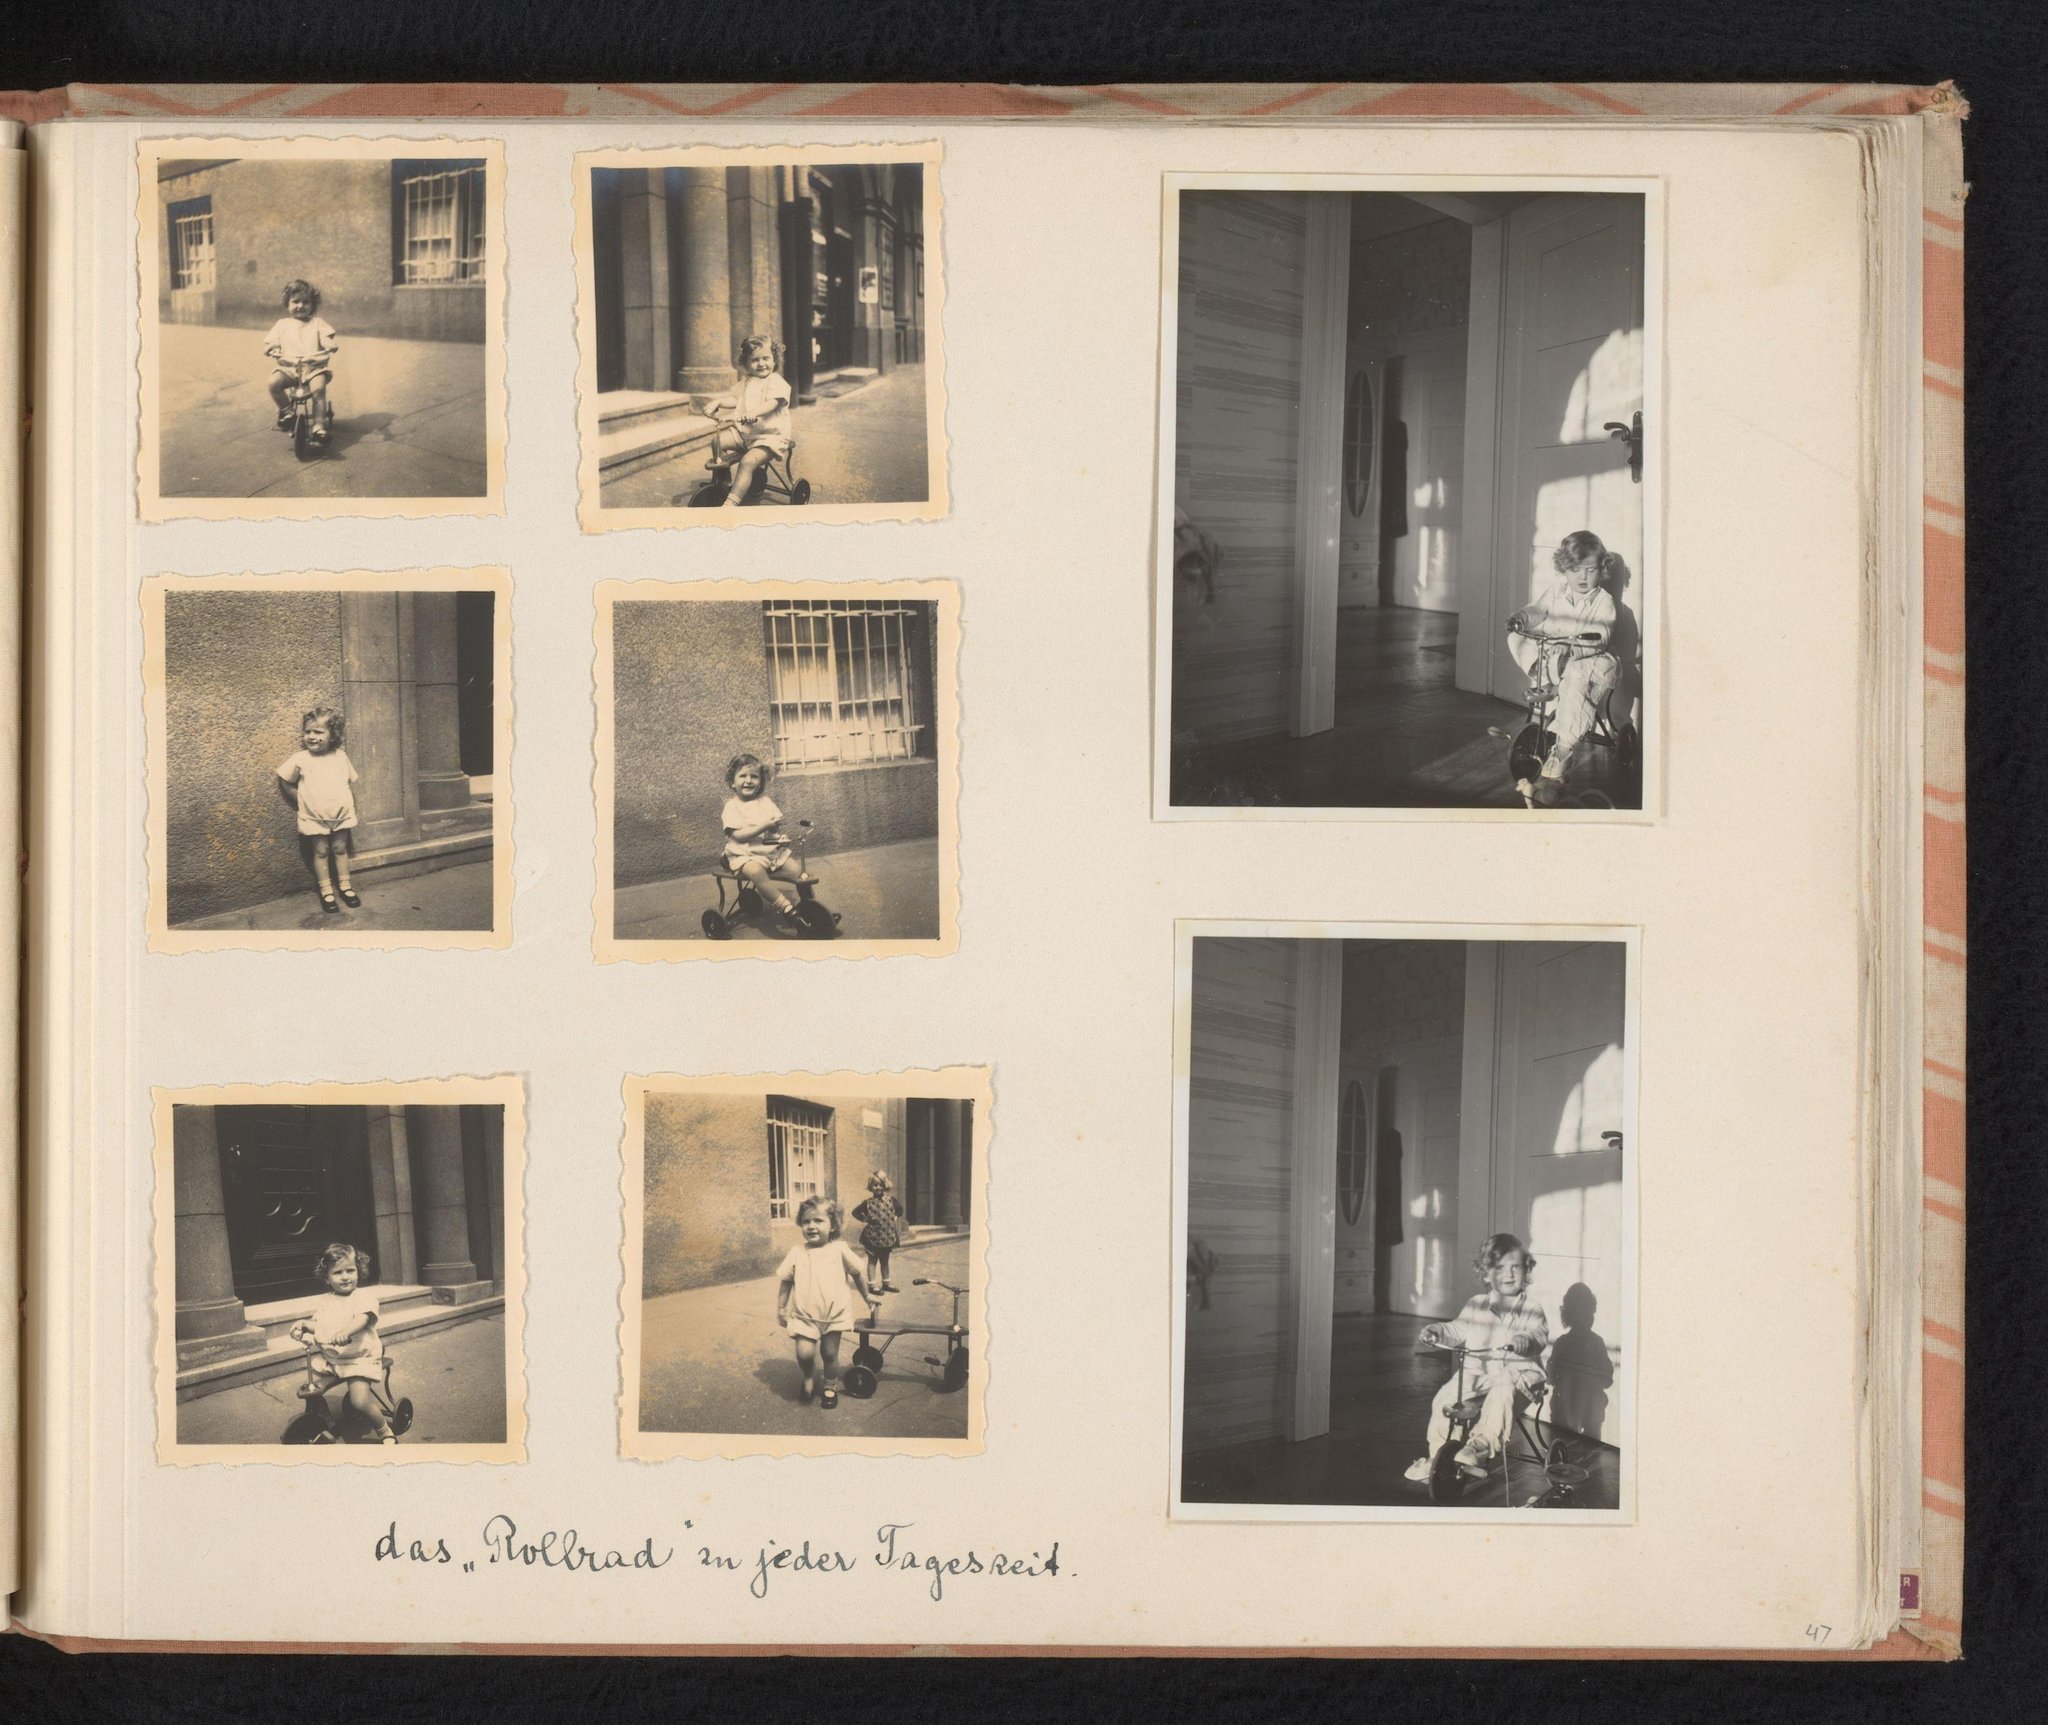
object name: album leaf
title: Isabel Wachenheimer op een driewieler in en voor de woning van de familie Wachenheimer, mei 1930, München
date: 1905-1930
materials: paper, photographic support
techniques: gelatin silver print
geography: munich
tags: leiden, isabel wachenheimer-elon, tricycle, family life at home, mother and baby or young child, infant, baby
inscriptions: inscription: ‘das ,,Rolbrad" zu jeden Tageszeit.’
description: Albumblad met acht foto's. Alle foto's, Isabel Wachenheimer. Foto midden onder, met onbekend meisje. Onderdeel van het fotoalbum met foto's van Isabel Wachenheimer als kind (1928-1931).